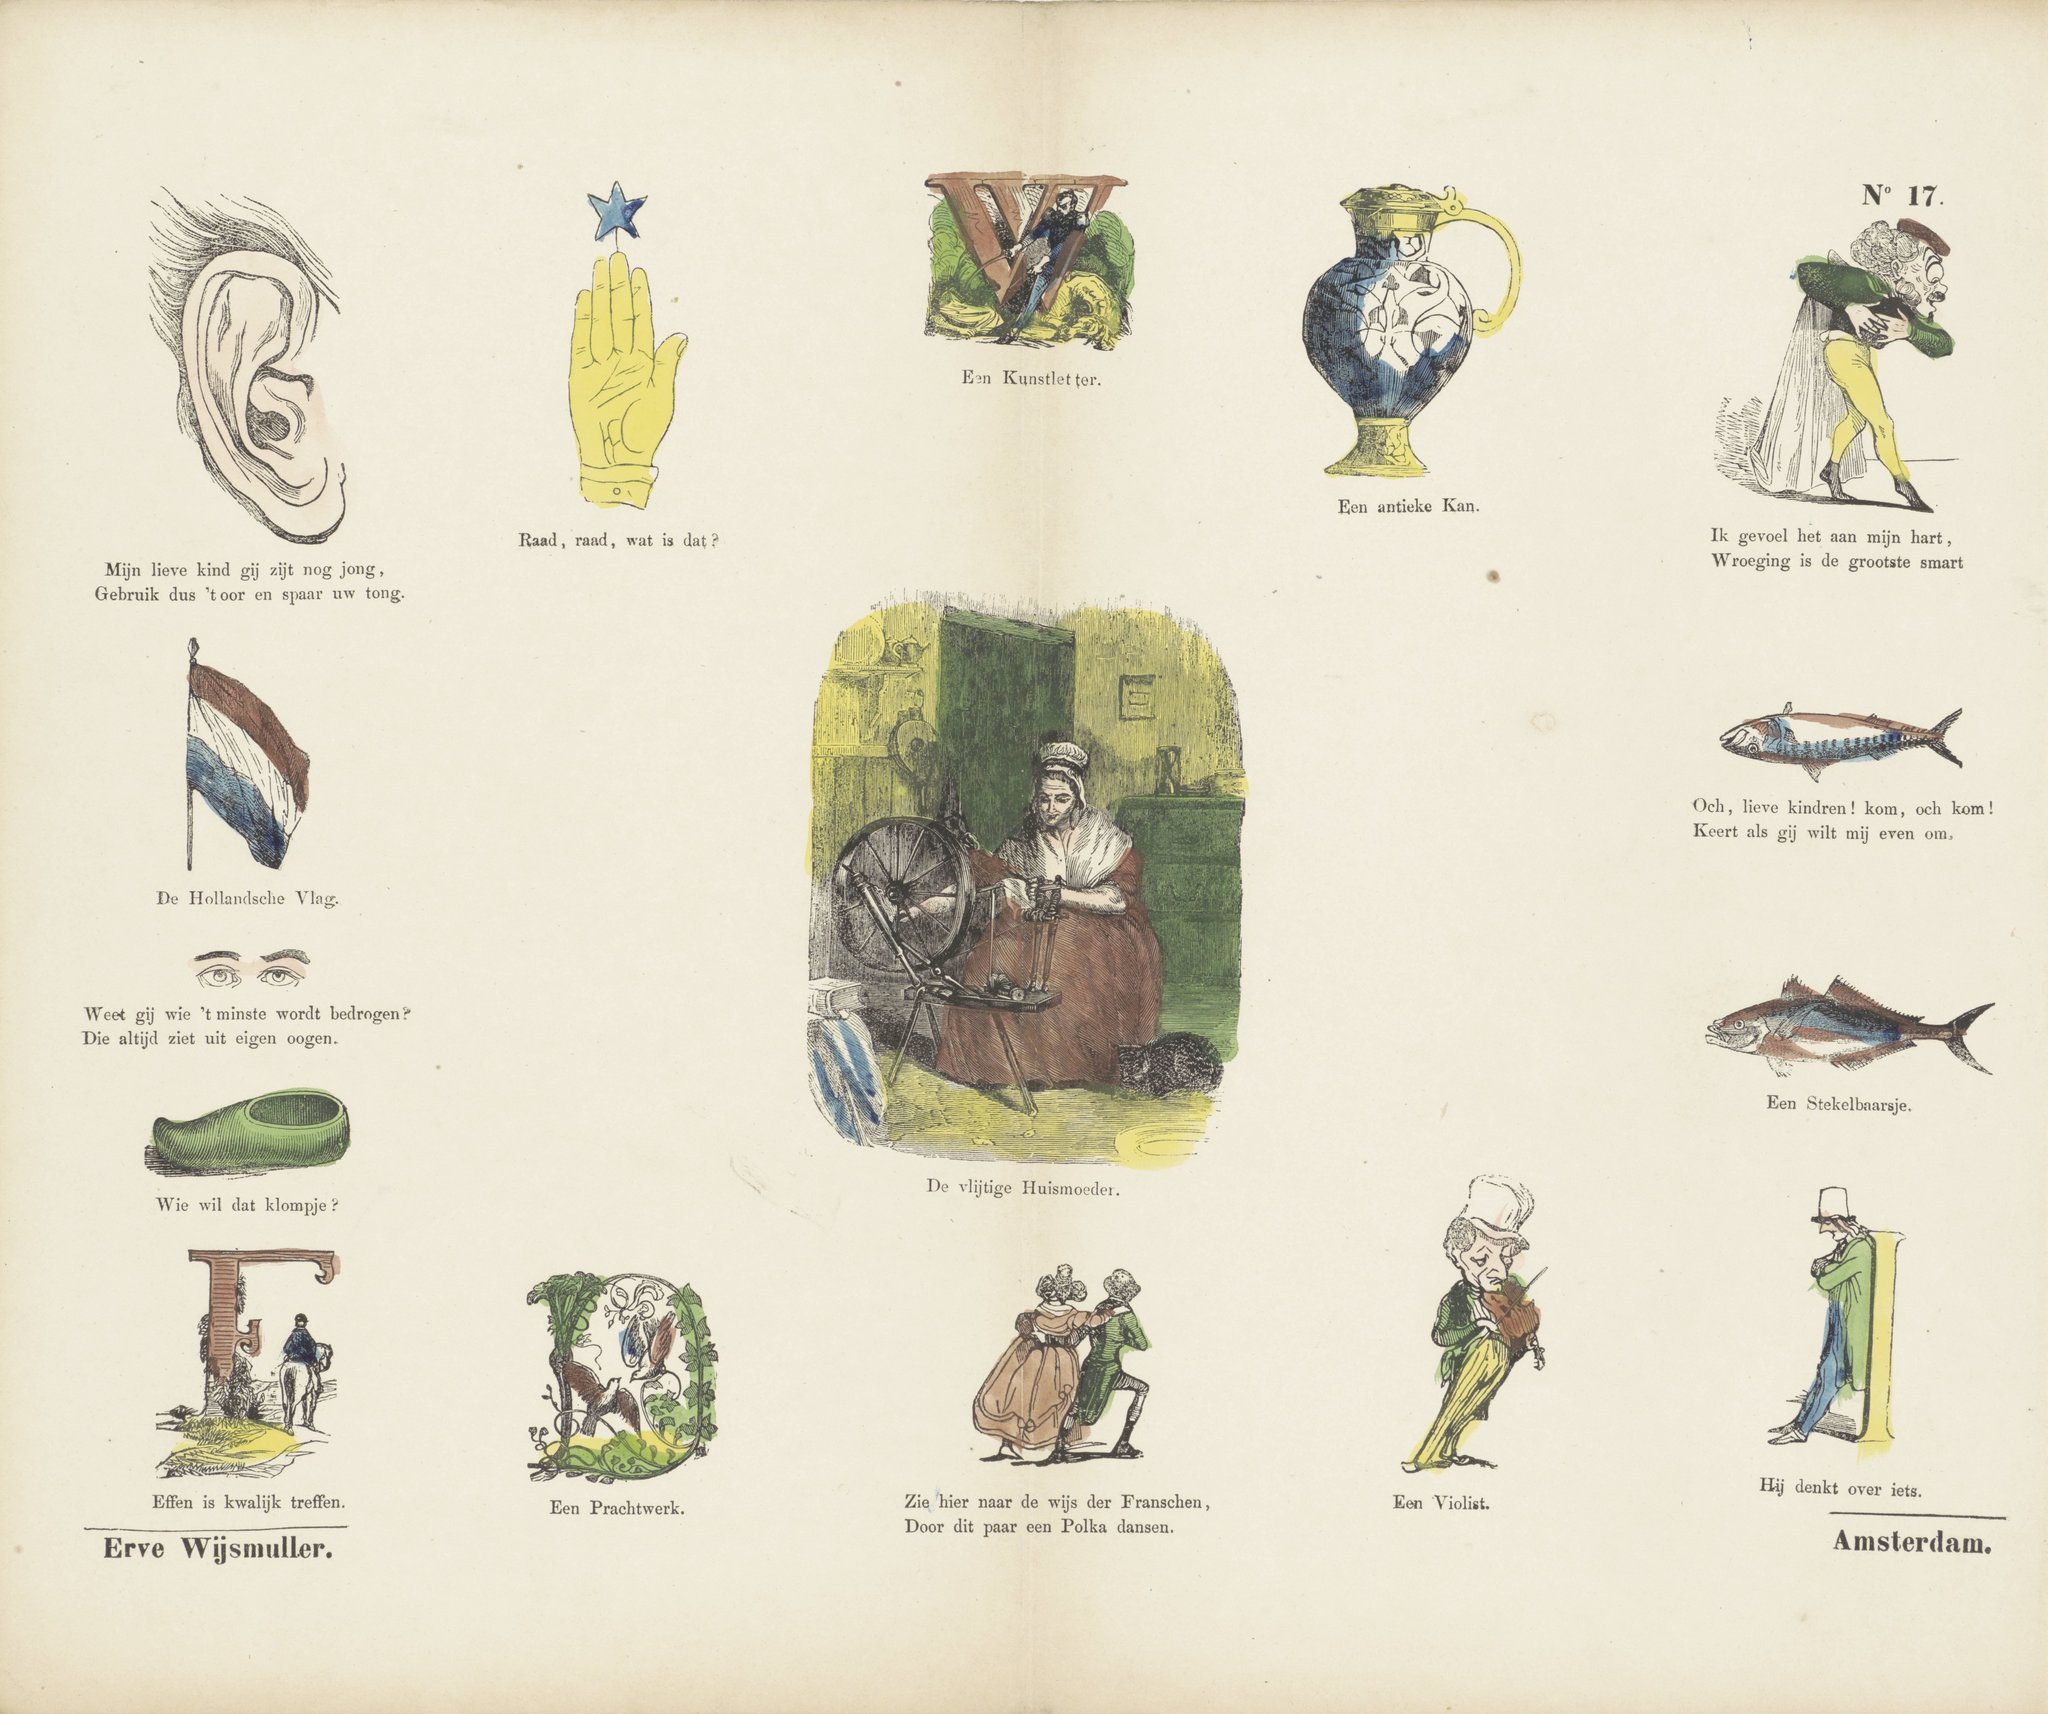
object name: popular print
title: Verschillende voorstellingen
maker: Anonymous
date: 1828-1913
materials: paper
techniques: colour, letterpress printing, line block, engraving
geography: netherlands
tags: letters, alphabet, script, fishes, eyes, ears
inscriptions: collector's mark: Lugt 2760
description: Blad met 16 voorstellingen van verschillende aard, waaronder een oor, een antieke kan, vissen, een violist en de Nederlandse vlag. Onder elke afbeelding een onderschrift. Onder de eerste afbeelding het onderschrift: Mijn lieve kind gij zijn nog jong... Genummerd rechtsboven: No. 17.